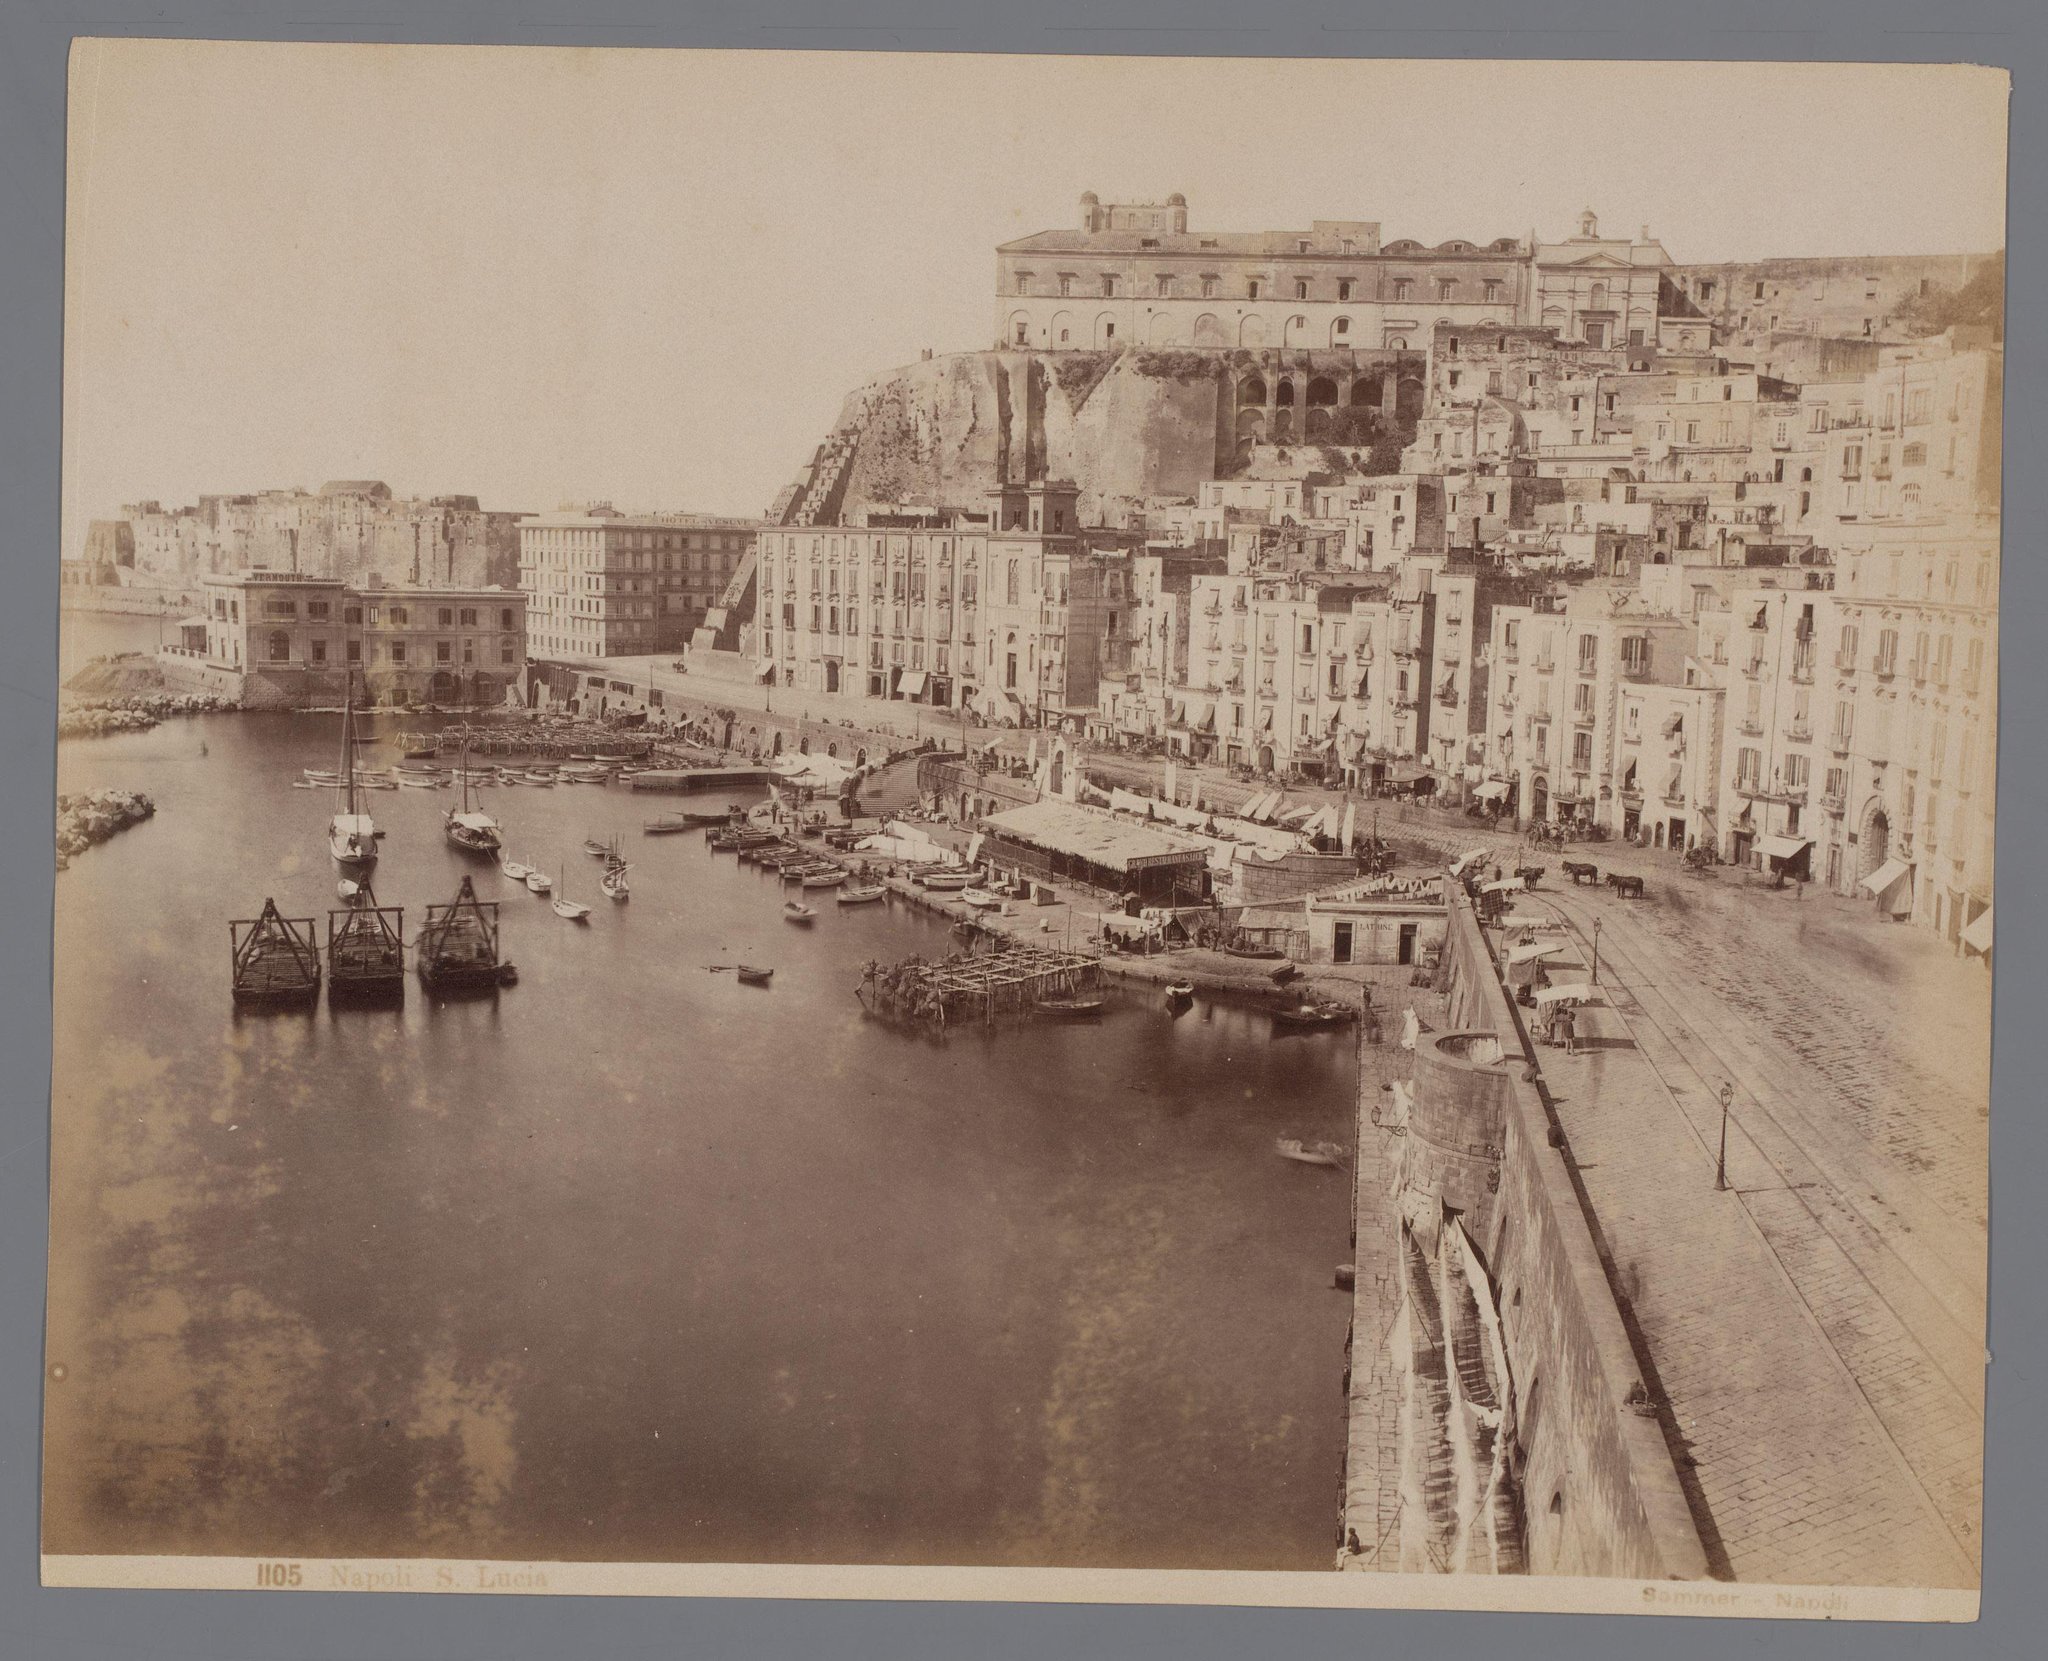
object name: photograph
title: Napoli S. Lucia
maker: giorgio sommer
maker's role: fotograaf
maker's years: 1834-1914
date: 1857-1914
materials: paper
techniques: albumen print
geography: naples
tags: harbour, city-view in general; 'veduta', pier, quay, wharf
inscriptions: inscription: ‘Napels Santa Lucia’, number: ‘1105’